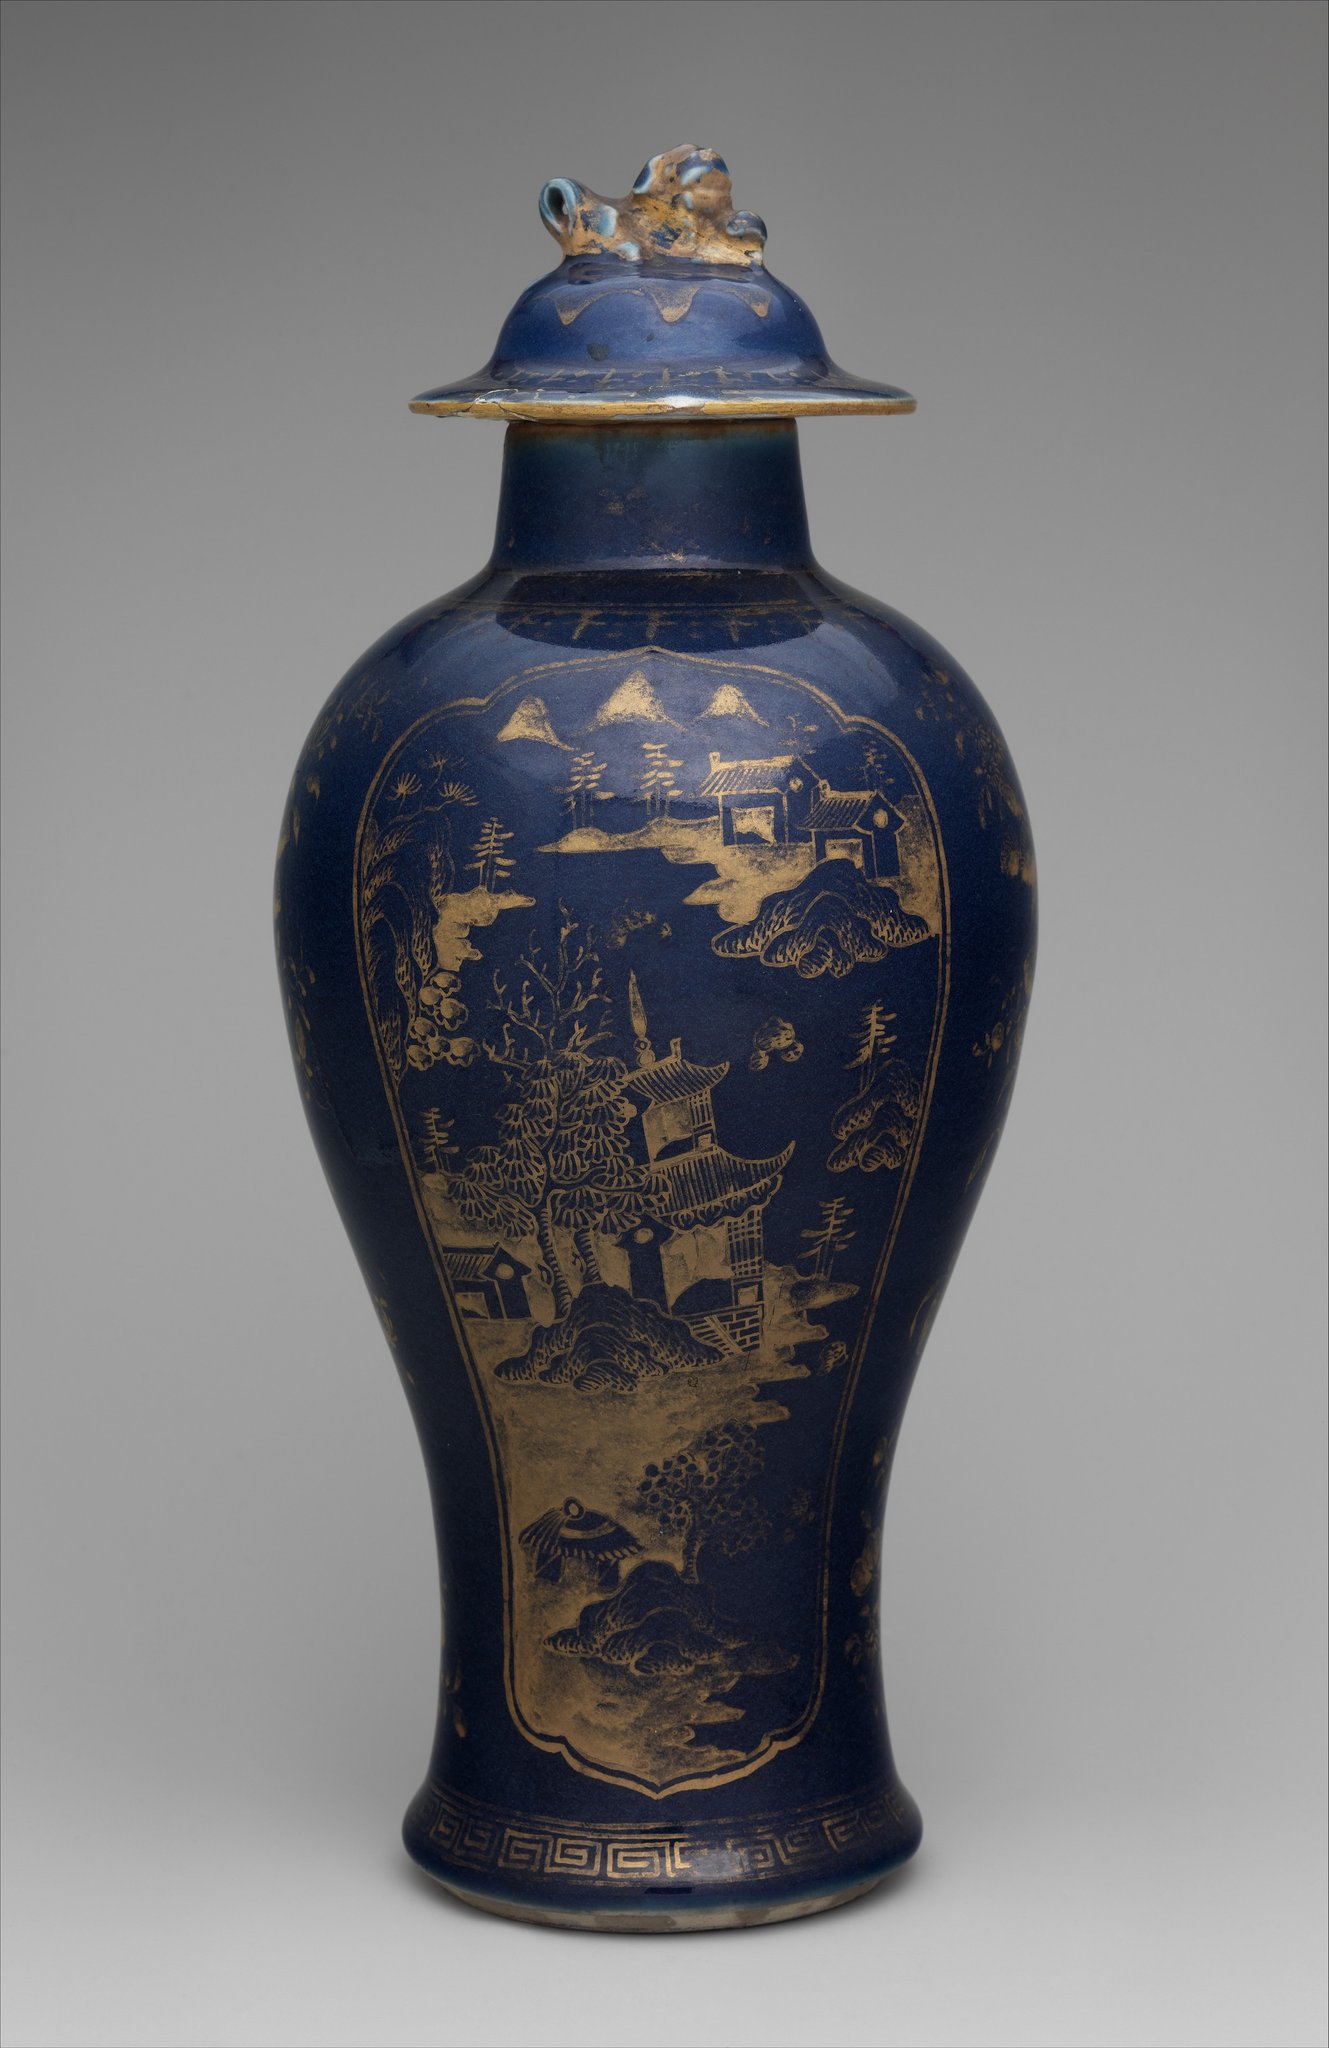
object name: vase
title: Covered Vase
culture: chinese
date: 1770-1795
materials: porcelain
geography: china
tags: landscapes